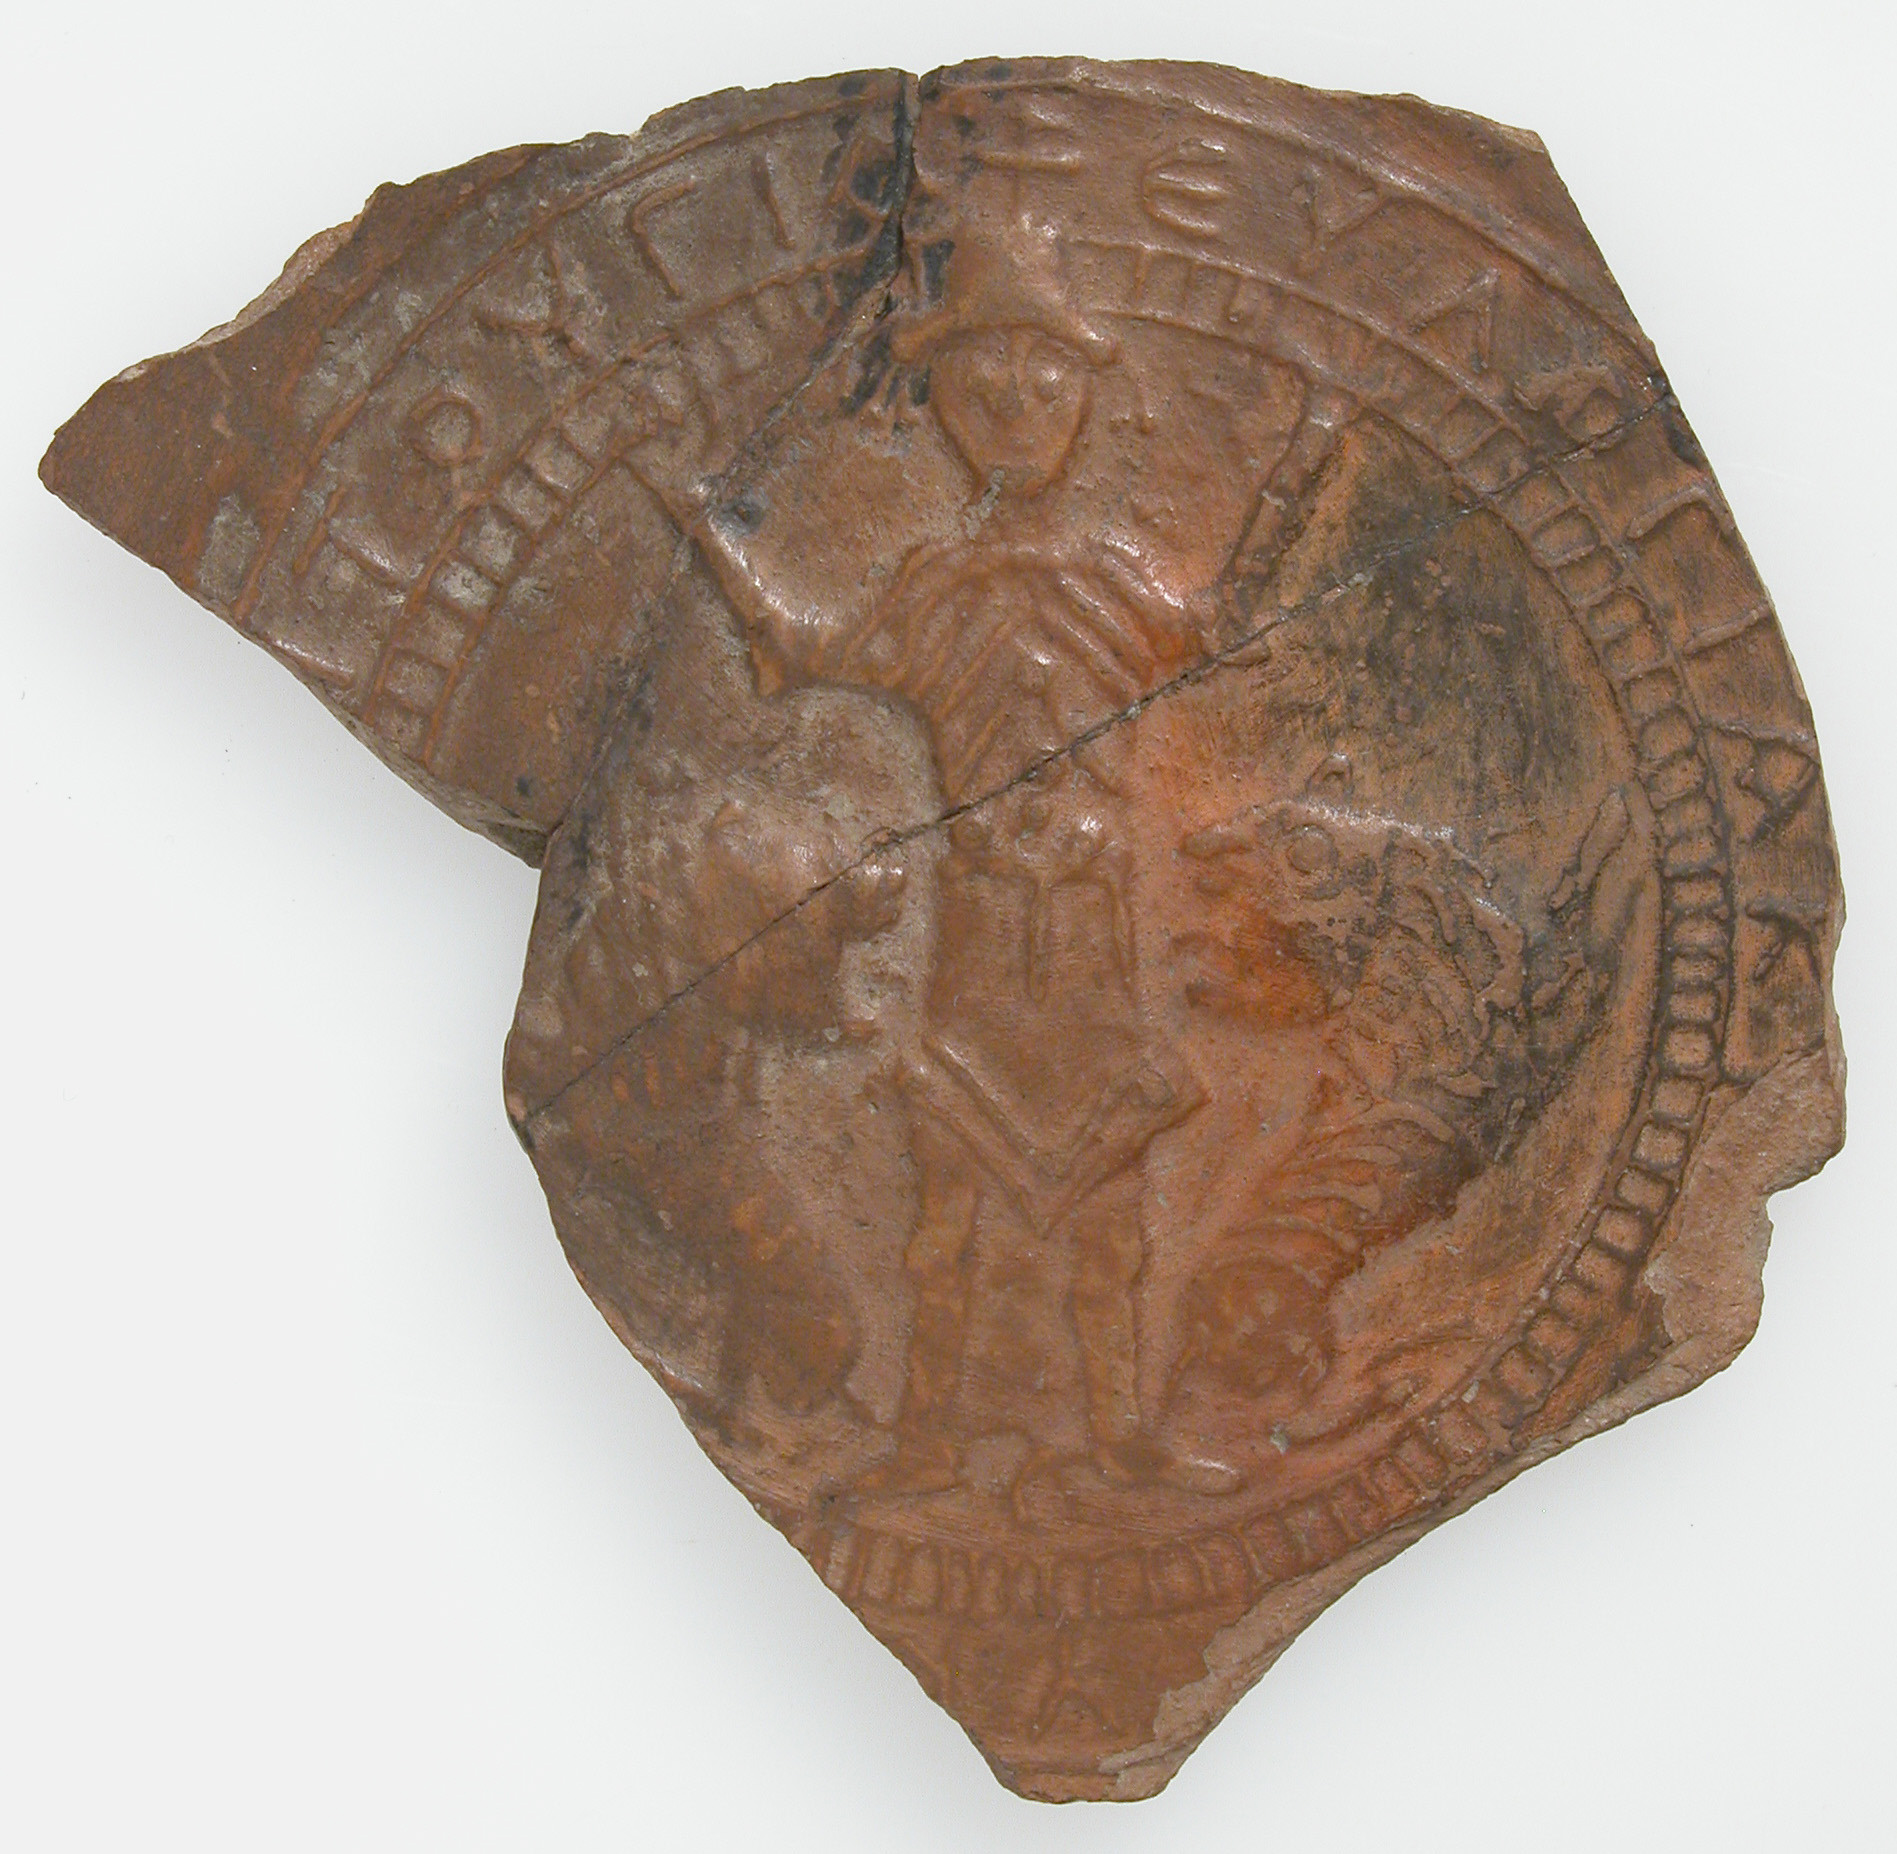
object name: plaque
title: Pilgrim's Plaque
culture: coptic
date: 301-700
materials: earthenware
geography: egypt